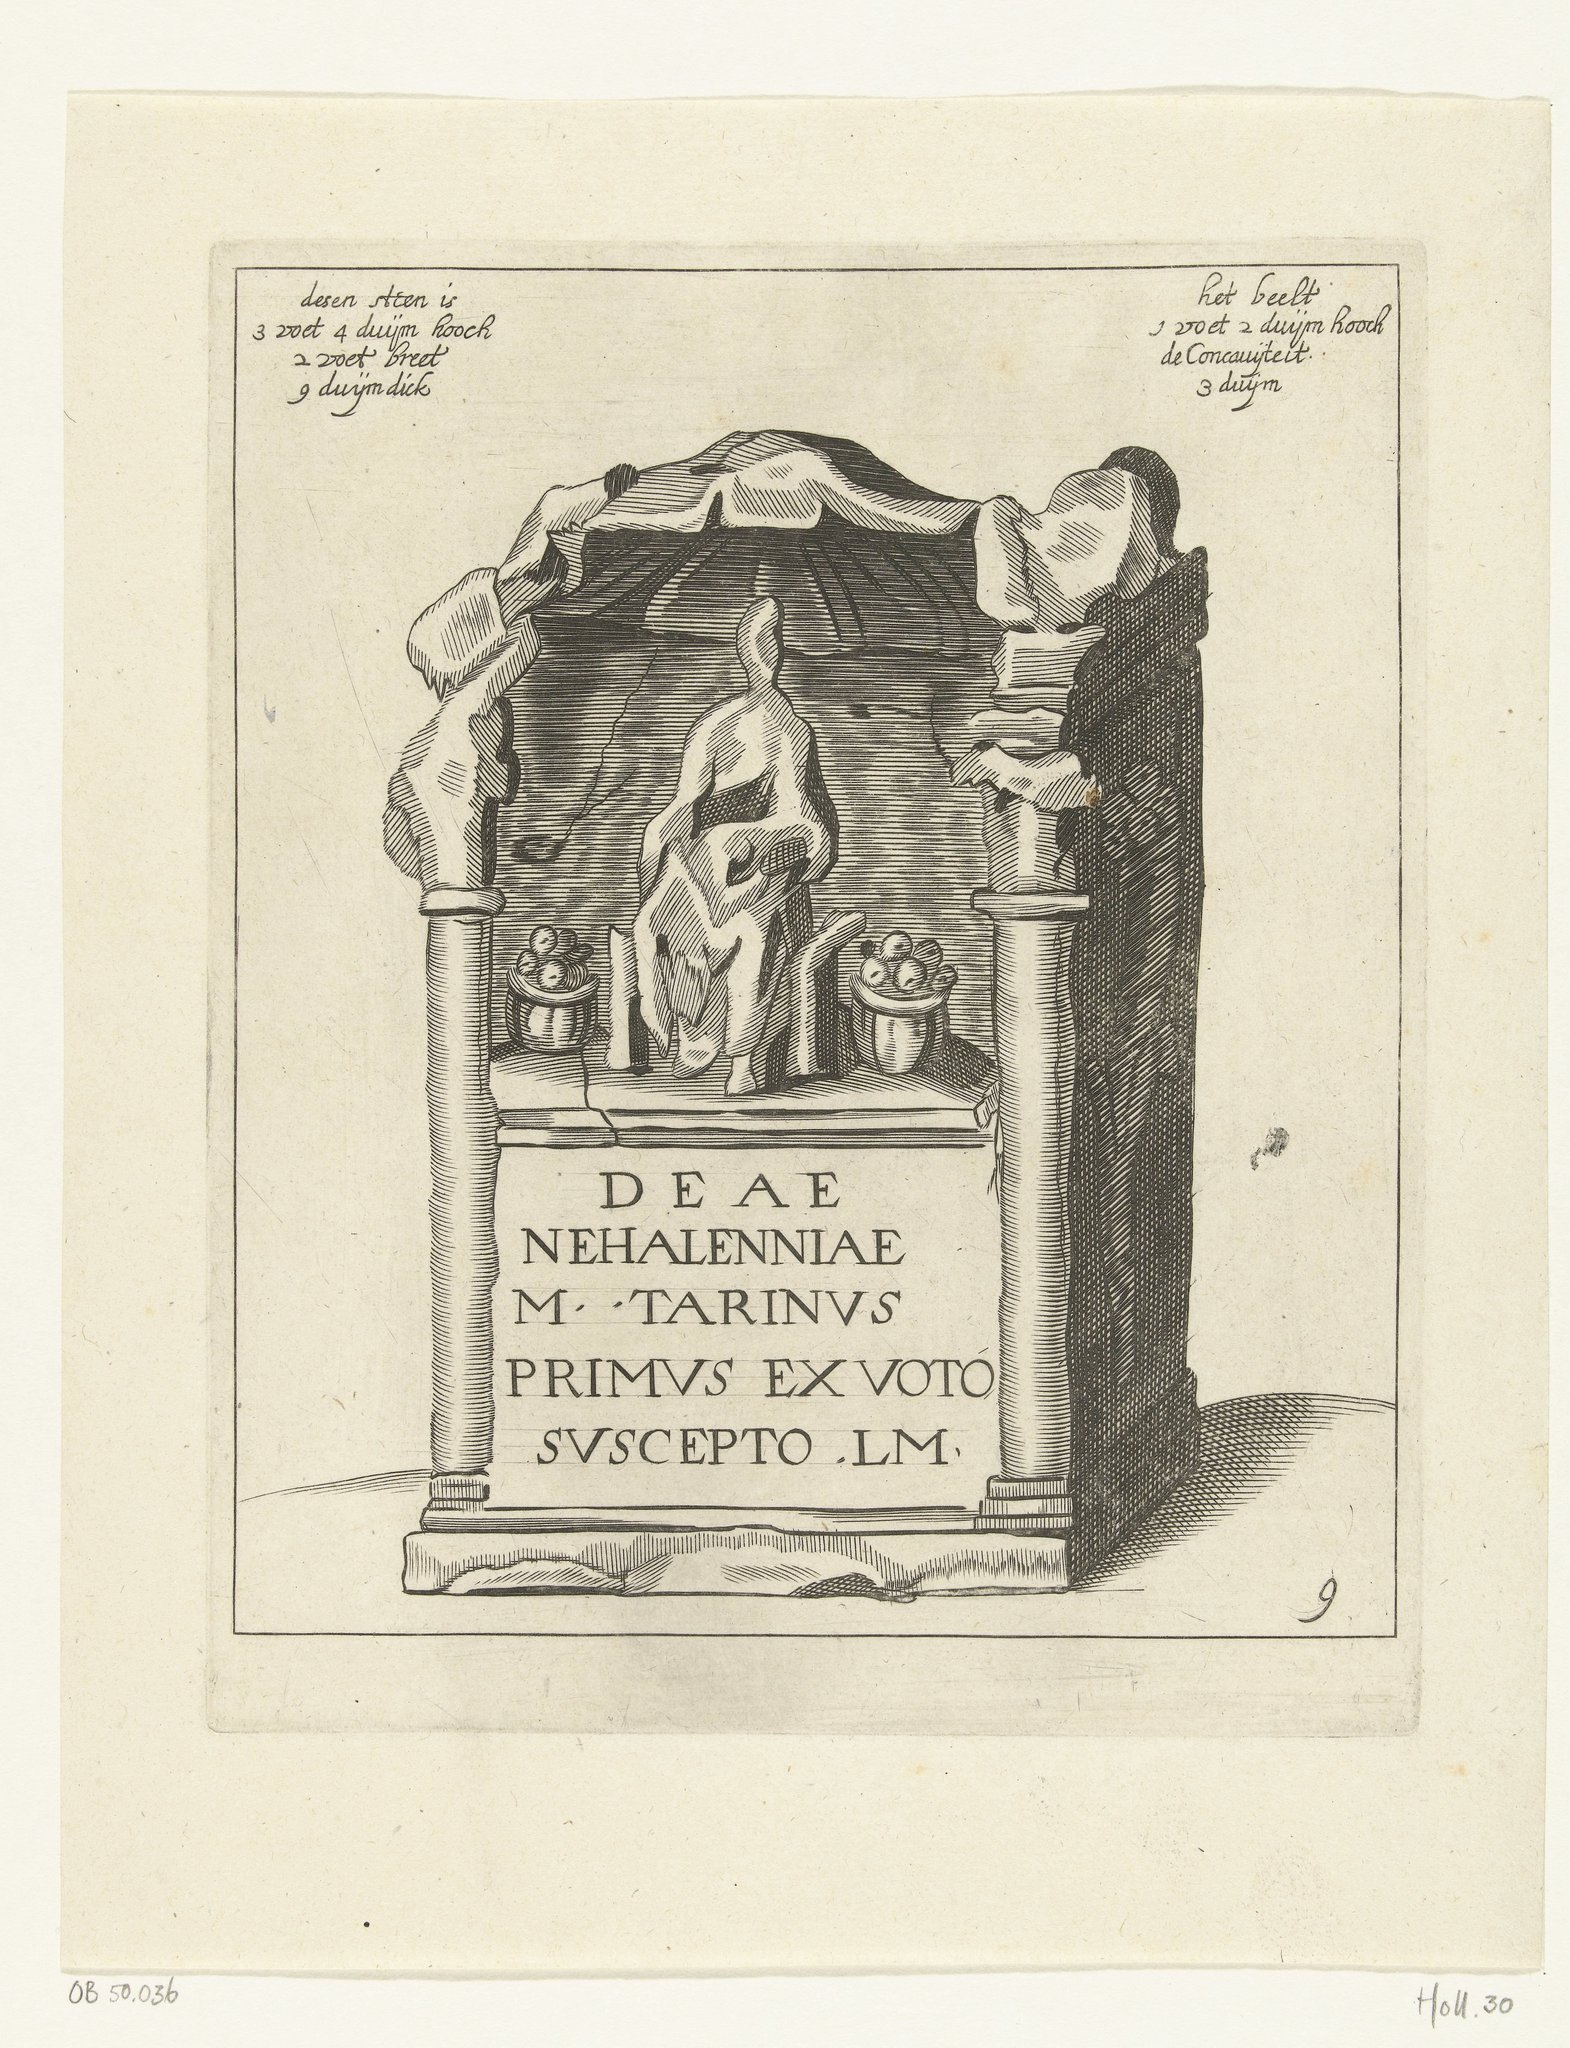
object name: print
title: Oudheden gevonden op het strand van Walcheren in 1647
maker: hendrick danckerts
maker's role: print maker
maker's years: 1625-1679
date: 1647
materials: paper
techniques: engraving, etching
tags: other foreign deities included in the classical pantheon (with name)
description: Altaar van de Romeinse godin Nehalennia.